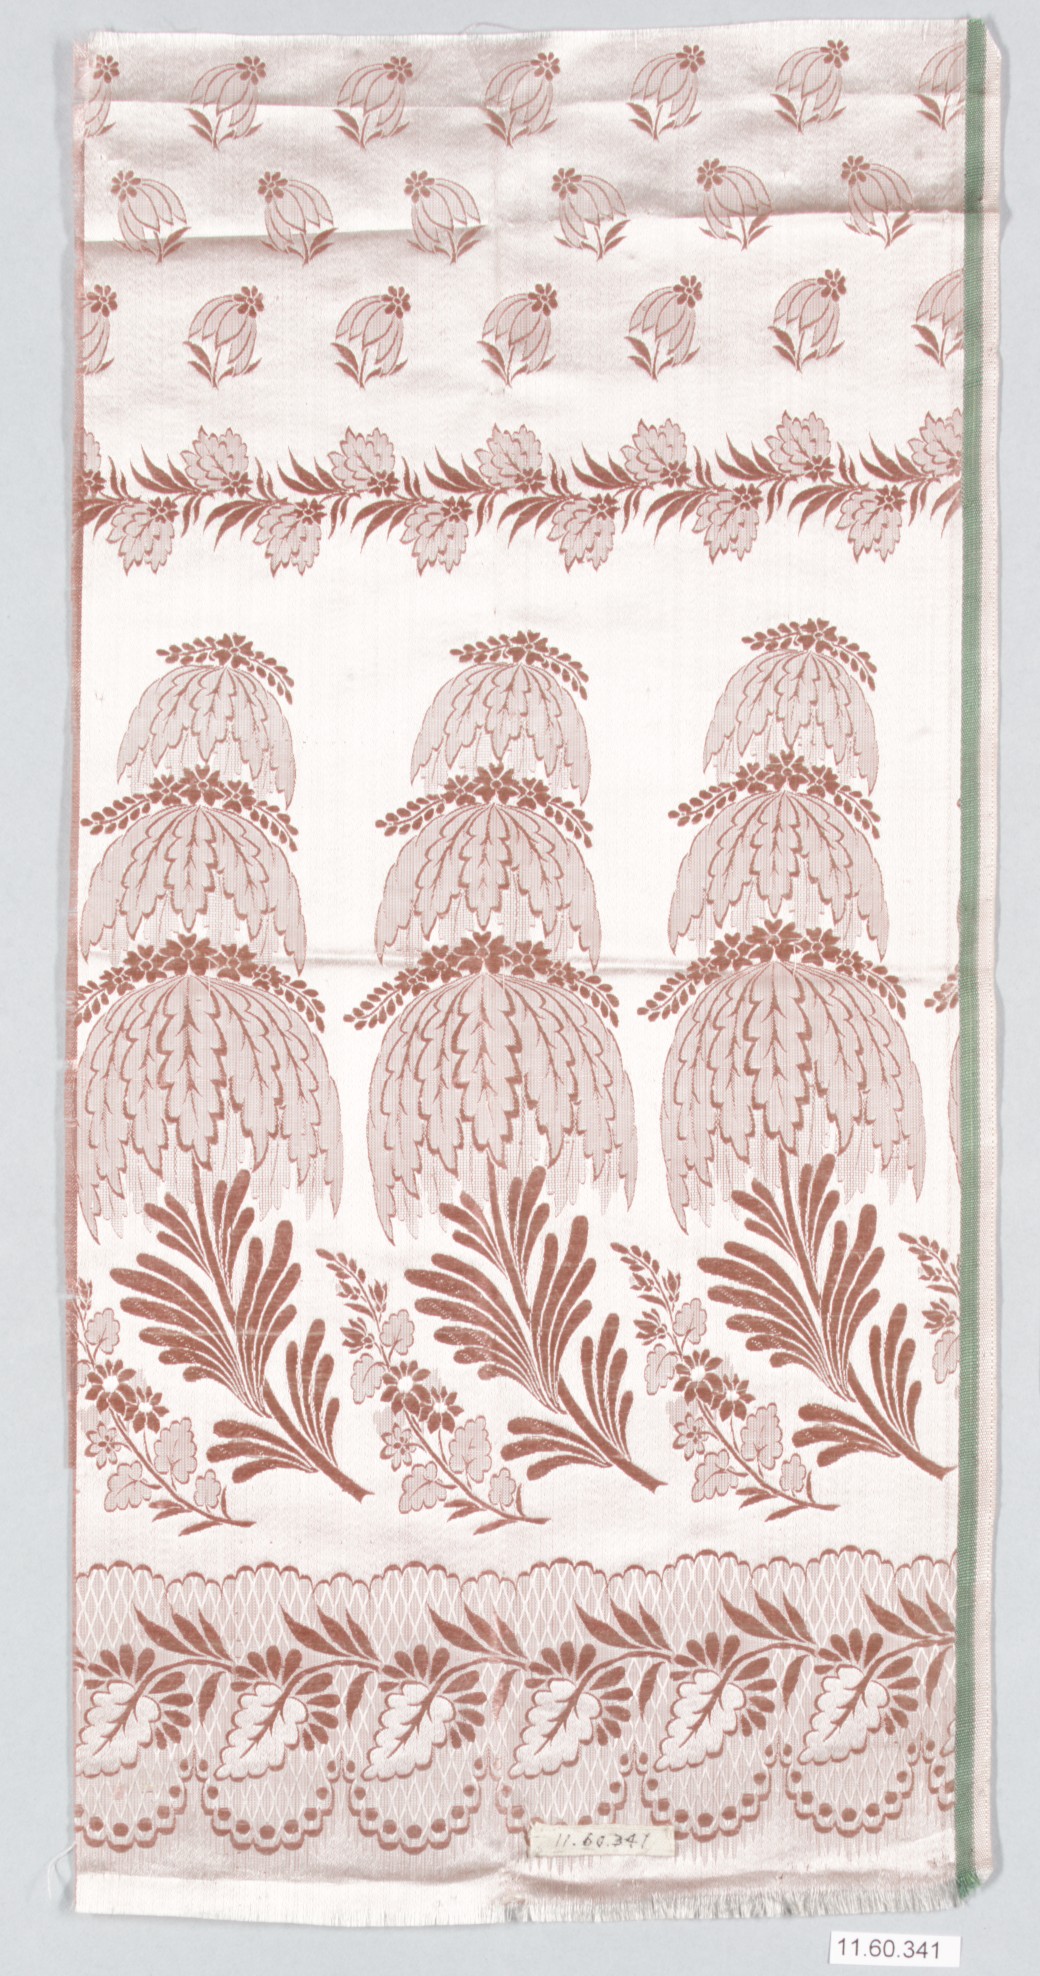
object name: fragment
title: Fragments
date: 1801-1900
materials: silk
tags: flowers,leaves